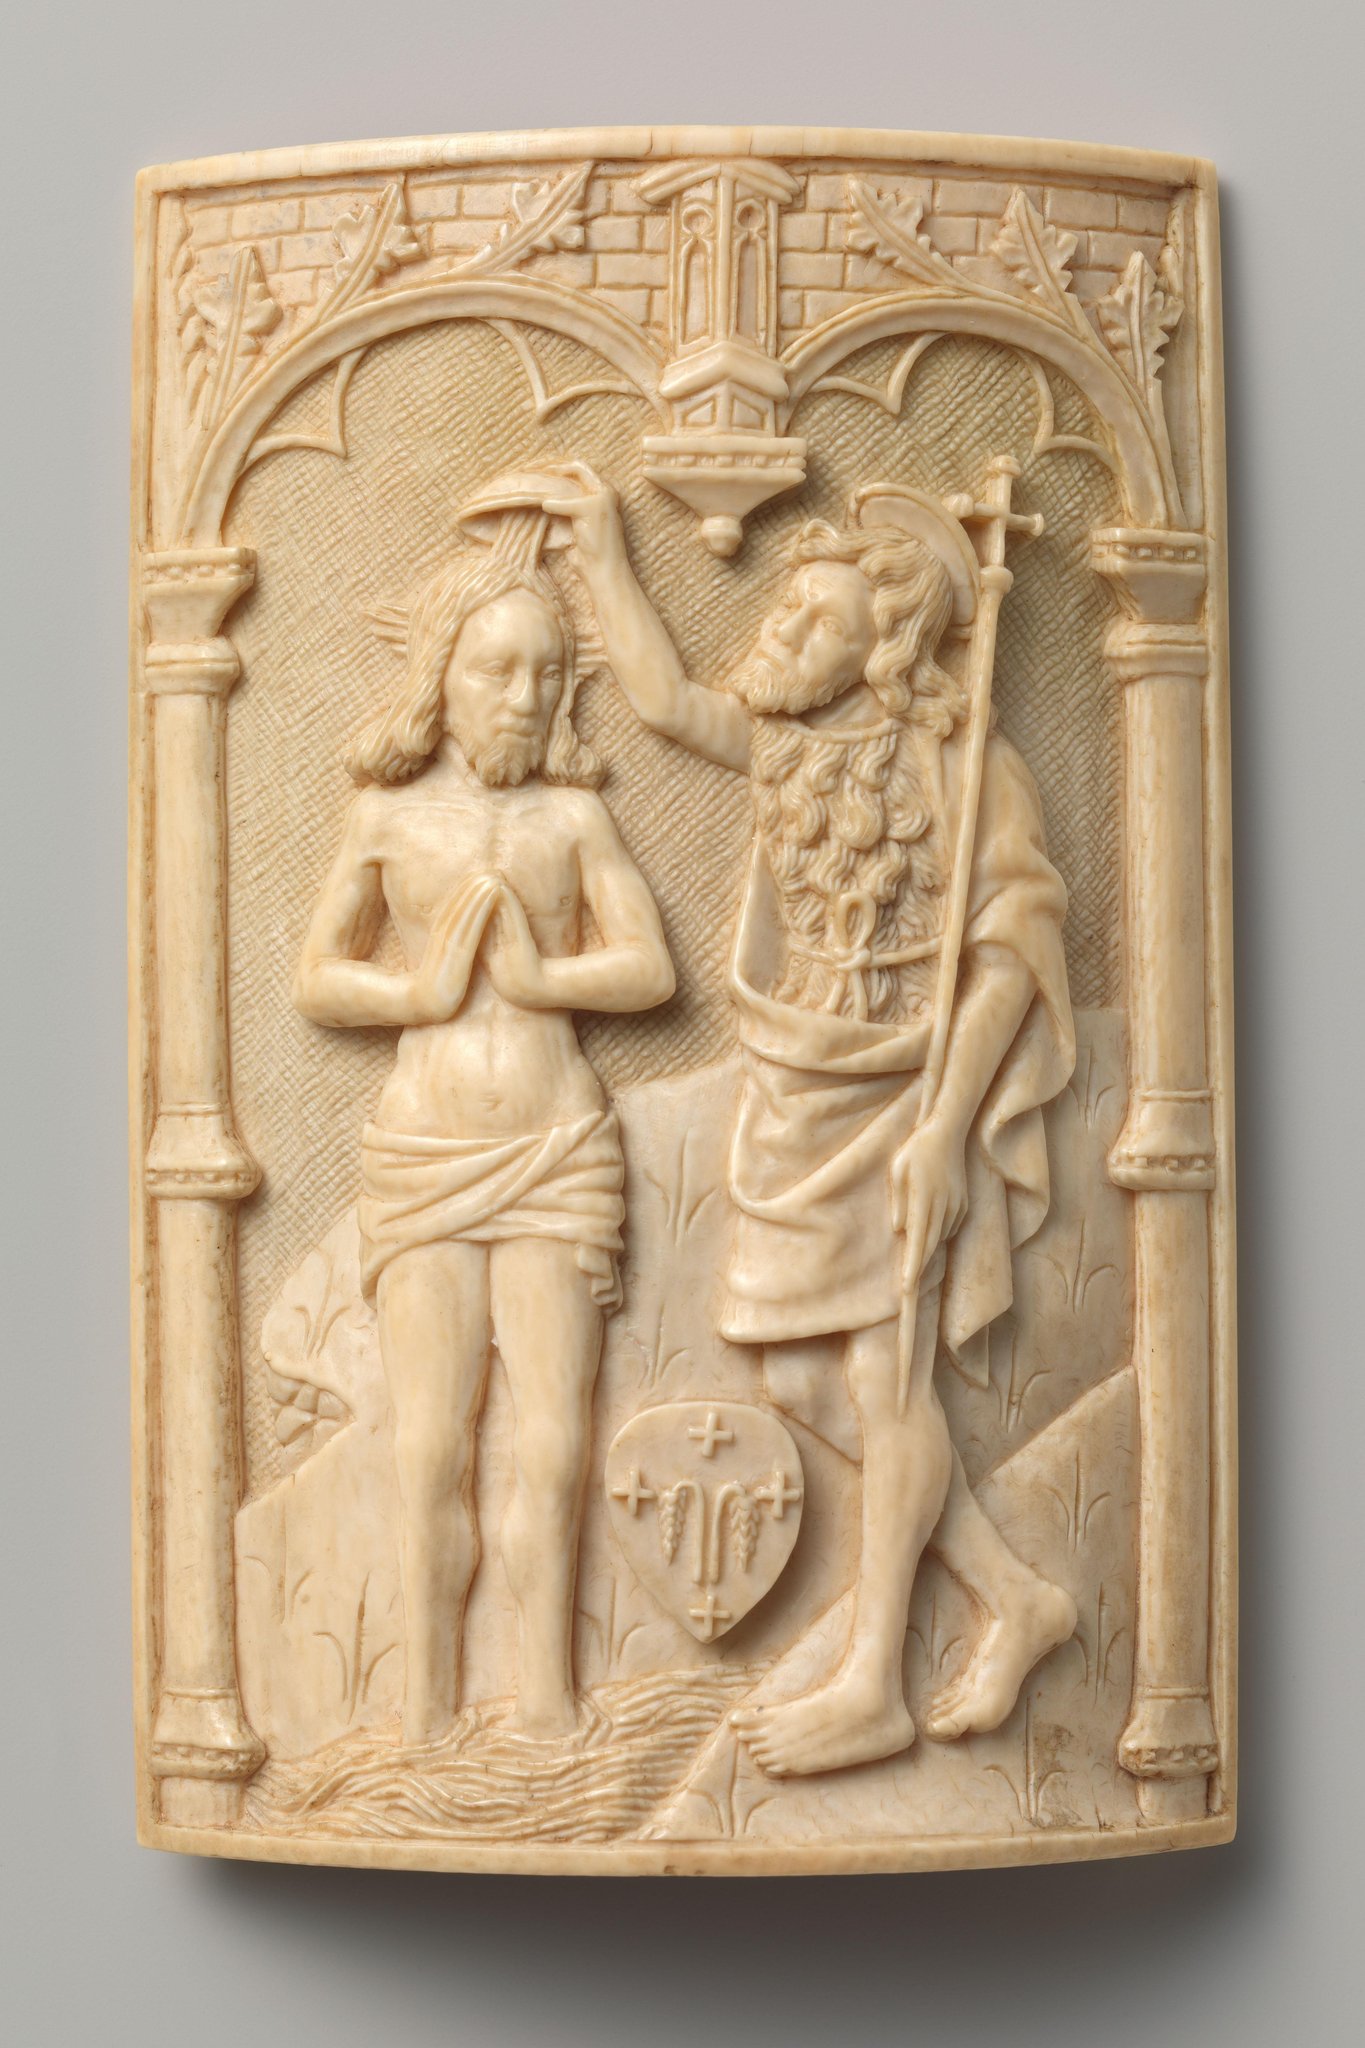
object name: pax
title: Pax with the Baptism of Christ in the River Jordan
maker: Anonymous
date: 1490-1520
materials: ivory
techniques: cutting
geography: northern france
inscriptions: inscription, on the same label, in blue ink: ‘4092 N[...] 39.’, inscription, on the same label, in black ink: ‘19882[...]NO.’, coat of arms, on the escutcheon in between Christ and John the Baptist, in relief: two hanging ears of corn and four crosses (Baldovini Del Pannocchia family), inscription, partly covered by the label on the reverse, in brown ink: an old illegible number, inscription, on a label on the reverse, in brown ink: ‘Pace in avorio Lavora del Sec.lo XIV’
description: De schenking is gedaan omdat dit relief het directe voorbeeld lijkt te zijn geweest voor een terracotta mal en afdruk in onze collectie (BK-2010-9-1,2). Daarmee is dit werk van groot belang als bewijsstuk voor de overdracht van hoge kunst naar lagere, massa geproduceerde kunstwerken in de late Middeleeuwen. Bovendien biedt het een sterke aanwijzing dat dit ivoor en de groep waartoe het stilistisch gerekend wordt en waarvan het Rijksmuseum enkele andere voorbeelden bezit ook in de Nederlanden is vervaardigd. Het wapenschild in het ivoor is duidelijk weggesneden uit de mal, toen de klei nog niet geheel droog was.